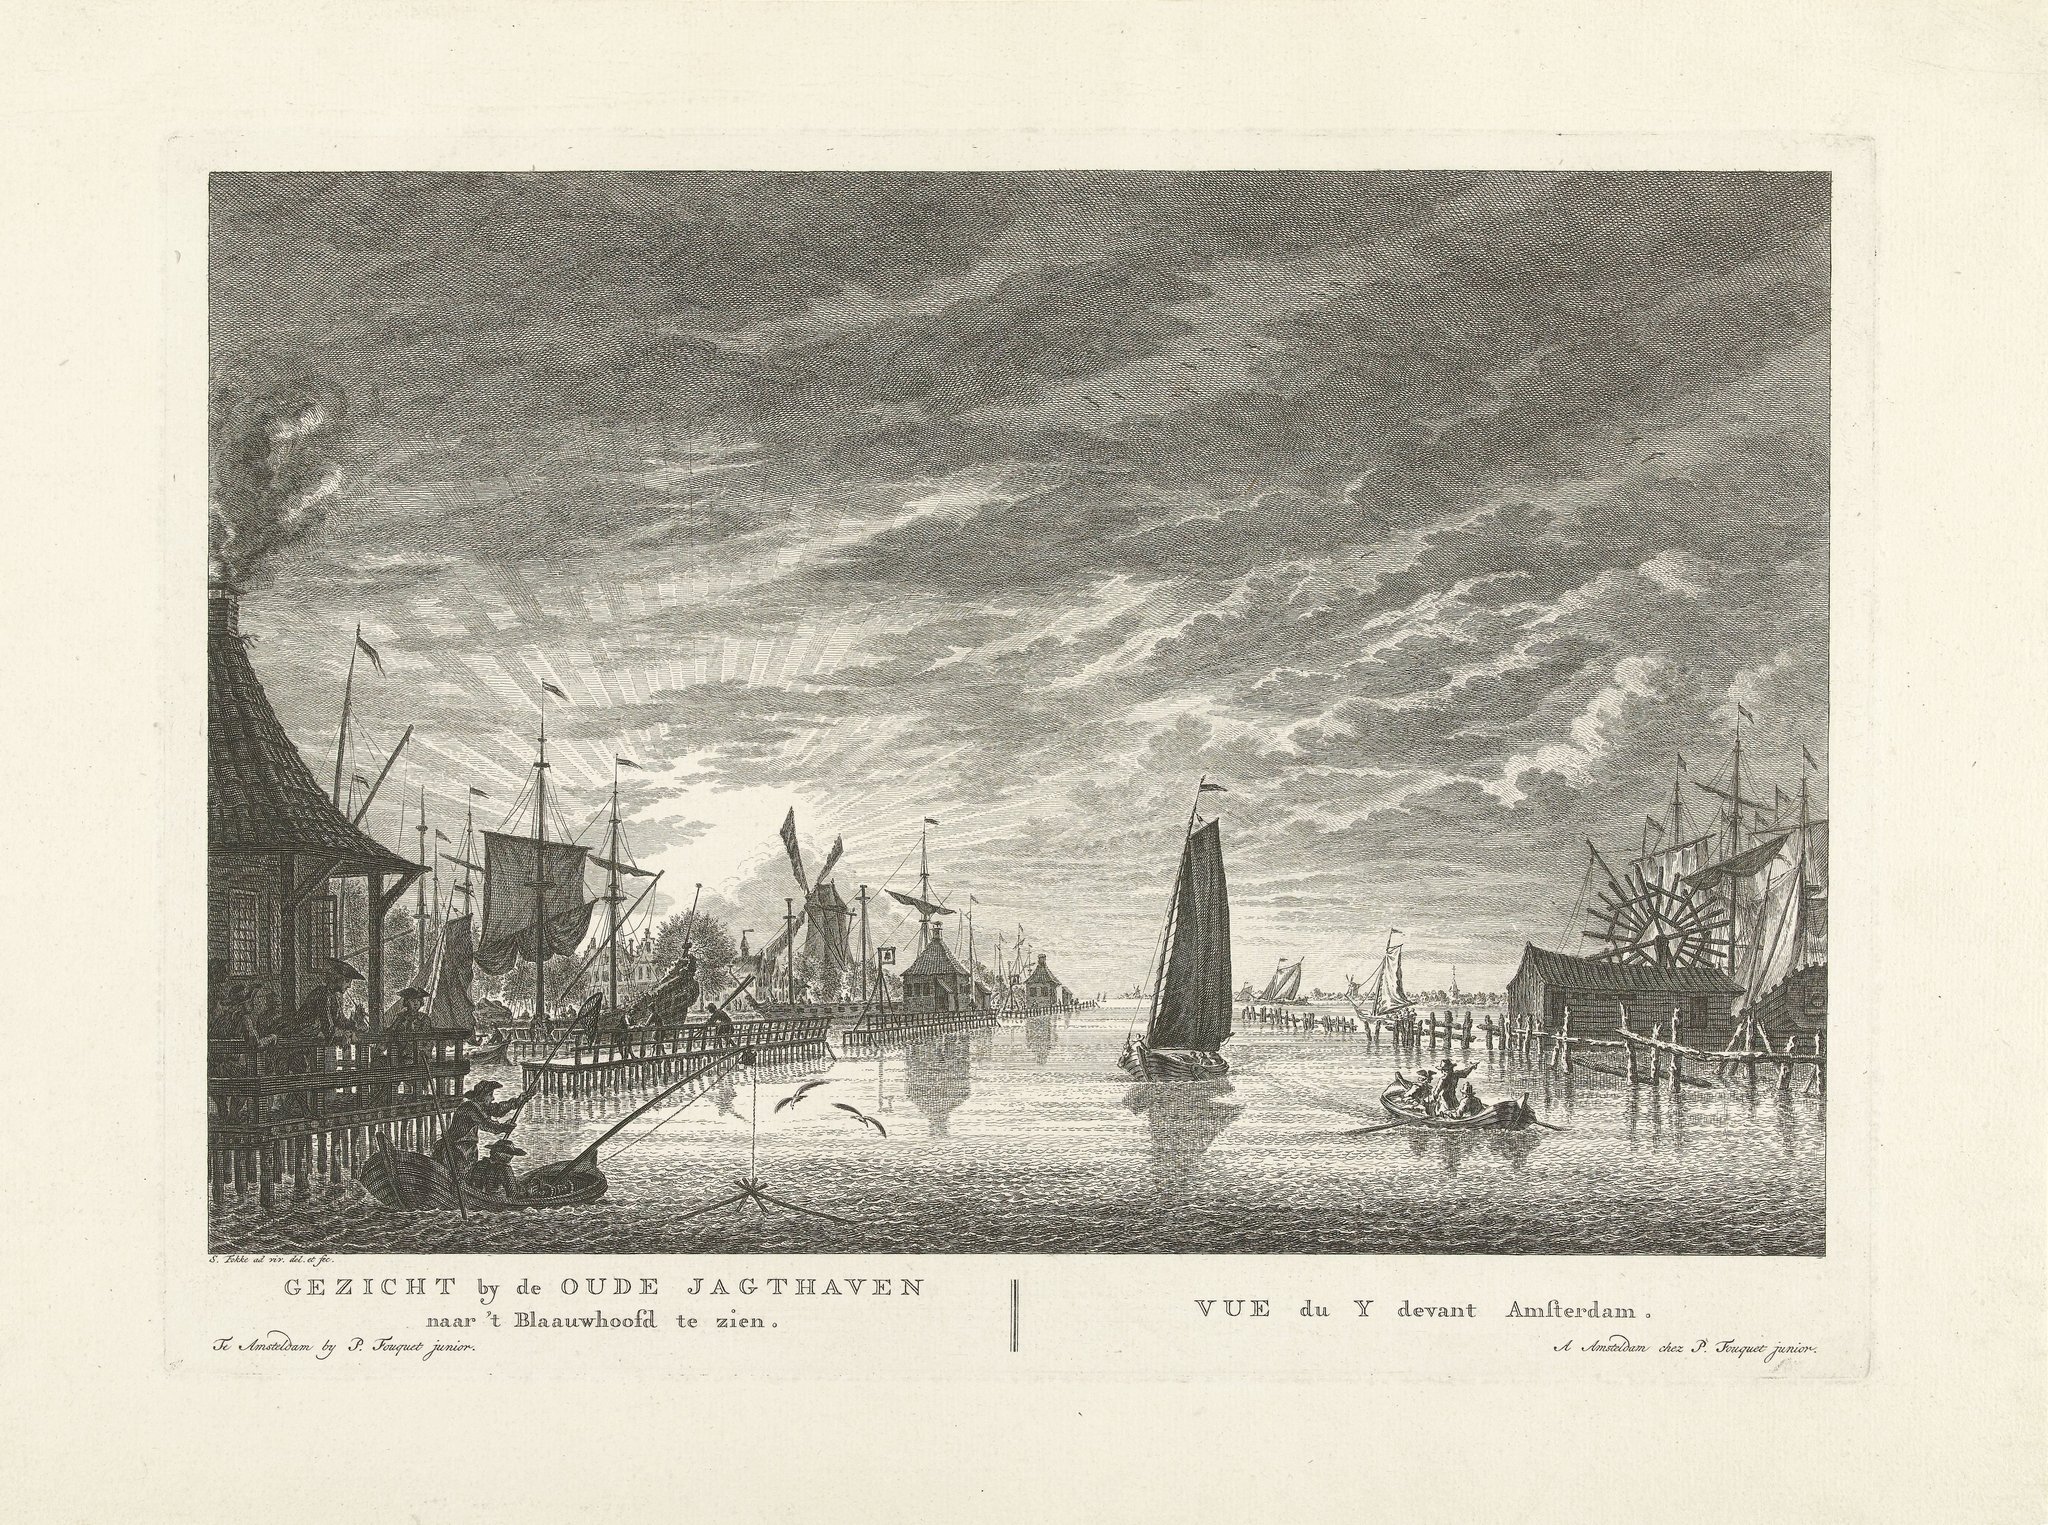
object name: print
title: Gezicht by de Oude Jagthaven naar 't Blaauwhooft te zien / Vue du Y devant Amsterdam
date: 1762-1783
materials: paper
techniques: engraving, etching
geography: amsterdam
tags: harbour, ships (in general), amsterdam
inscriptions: collector's mark: Lugt 2228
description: Deze prent is ook gebruikt in de zogenaamde Atlas van Fouquet.* Pierre Fouquet gaf vanaf 1760 stadsgezichten van Amsterdam - naar tekeningen van verschillende kunstenaars, gemaakt door verschillende prentmakers - uit. Deze prenten werden aanvankelijk los of in series verkocht. Zoals toen gebruikelijk kon de koper de prenten zelf laten inbinden. Hiertoe gaf Fouquet tussen 1778 en 1783 een titelblad, plattegrond en inhoudsopgave van de tot dusver 100 uitgegeven prenten uit (1). Gezien de inhoud afhankelijk was van wat de koper had verzameld verschilt de inhoud van de verschillende bewaarde Fouquetatlassen onder deze titel sterk. Ook zijn er exemplaren bekend waar tevens andere prenten aan zijn toegevoegd. Omdat er behoefte bleek aan uitleg bij de platen werd in 1783 een nieuwe versie van de atlas uitgegeven, aangevuld met tekst en twee prenten. De aangegeven volgorde veranderde maar de platen van de al eerder uitgegeven prenten bleven ongewijzigd. Deze uitgave werd in opdracht van Fouquet gedrukt bij Daniël Jean Changuion en Petrus den Hengst (2). Een tiental platen werd bijgewerkt en verscheen, met nieuw impressum, in het vervolg van Wagenaars geschiedenis van Amsterdam, uitgeven door Petrus Conradi en Folkert van der Plaats (3). Een aantal jaar na het overlijden van Fouquet kwam Evert Maaskamp met een nieuwe uitgave van de atlas, met verbeterde tekst en toevoeging van twee prenten. Op alle platen verwijderde hij het oude en liet hij zijn eigen impressum zetten (4). De huidige staat van de prent komt voor in exemplaren van de onder (1) en (2) genoemde werken. * Onder de Atlas van Fouquet of Fouquetatlas verstaan we de hieronder vermelde publicaties (1), (2) en (4). (1). Afbeeldingen van de wyd-vermaarde koopstad Amsterdam benevens des zelvs voornaamste gebouwen en gezigten alle naar het leeven getekend / Receuil des edifices les plus considerables et des plus belles vues, de la fameuse ville d'Amsterdam, dessinées d'après nature. Amsterdam: Pierre Fouquet, 1778-1783. (2). Nieuwe atlas, van de voornaamste gebouwen en gezigten der stad Amsterdam, met derzelver beknopte beschryvingen. 2 delen. Amsterdam: Daniël Jean Changuion en Petrus den Hengst [in opdracht van Pierre Fouquet], 1783. (3). Stijl, Simon. Amsterdam, in zyne geschiedenissen, voorregten, koophandel, gebouwen, kerkenstaat, schoolen, schutterye, gilden en regeeringe, beschreeven. Om te dienen ten vervolge op het werk van Jan Wagenaar (…). 10 delen. Amsterdam en Harlingen: Petrus Conradi en Folkert van der Plaats, 1788-1801. (4). Nieuwe atlas, van de voornaamste gebouwen en gezigten der stad Amsterdam. Met derzelver beknopte beschryvingen. Amsterdam: Evert Maaskamp, 1805. * Het aantal vermelde staten is gebaseerd op het aantal gevonden staten. Mogelijk zijn er meer staten van deze prent. Tekening in collectie Stadsarchief Amsterdam. Zie RP-P-AO-25-83 voor latere staat.